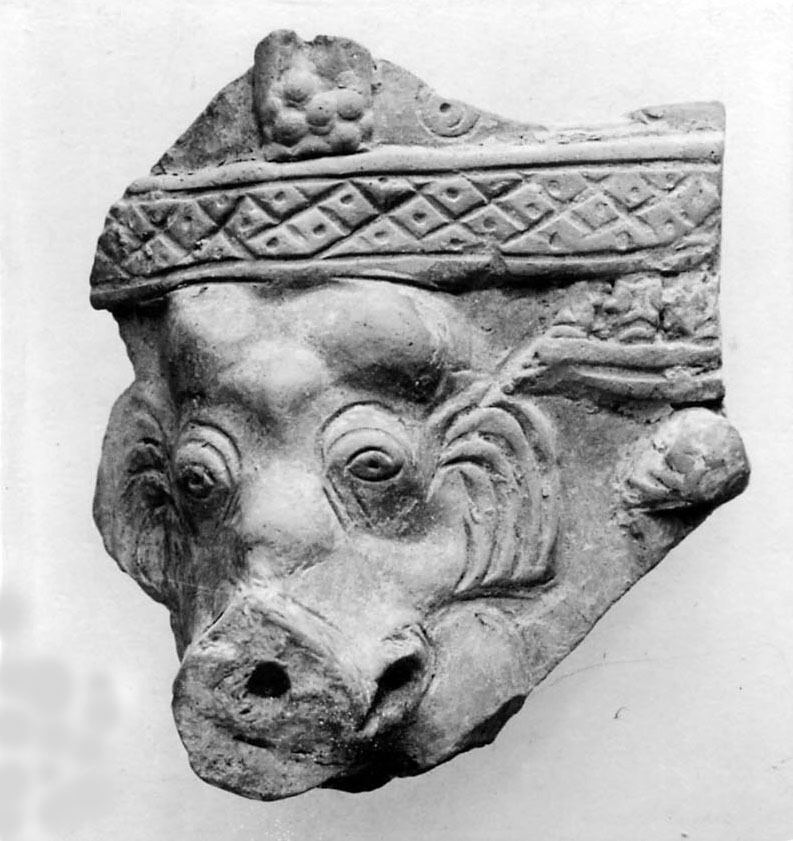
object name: relief fragment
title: Fragment of a Relief Ornament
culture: central asian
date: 1101-1200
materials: terracotta